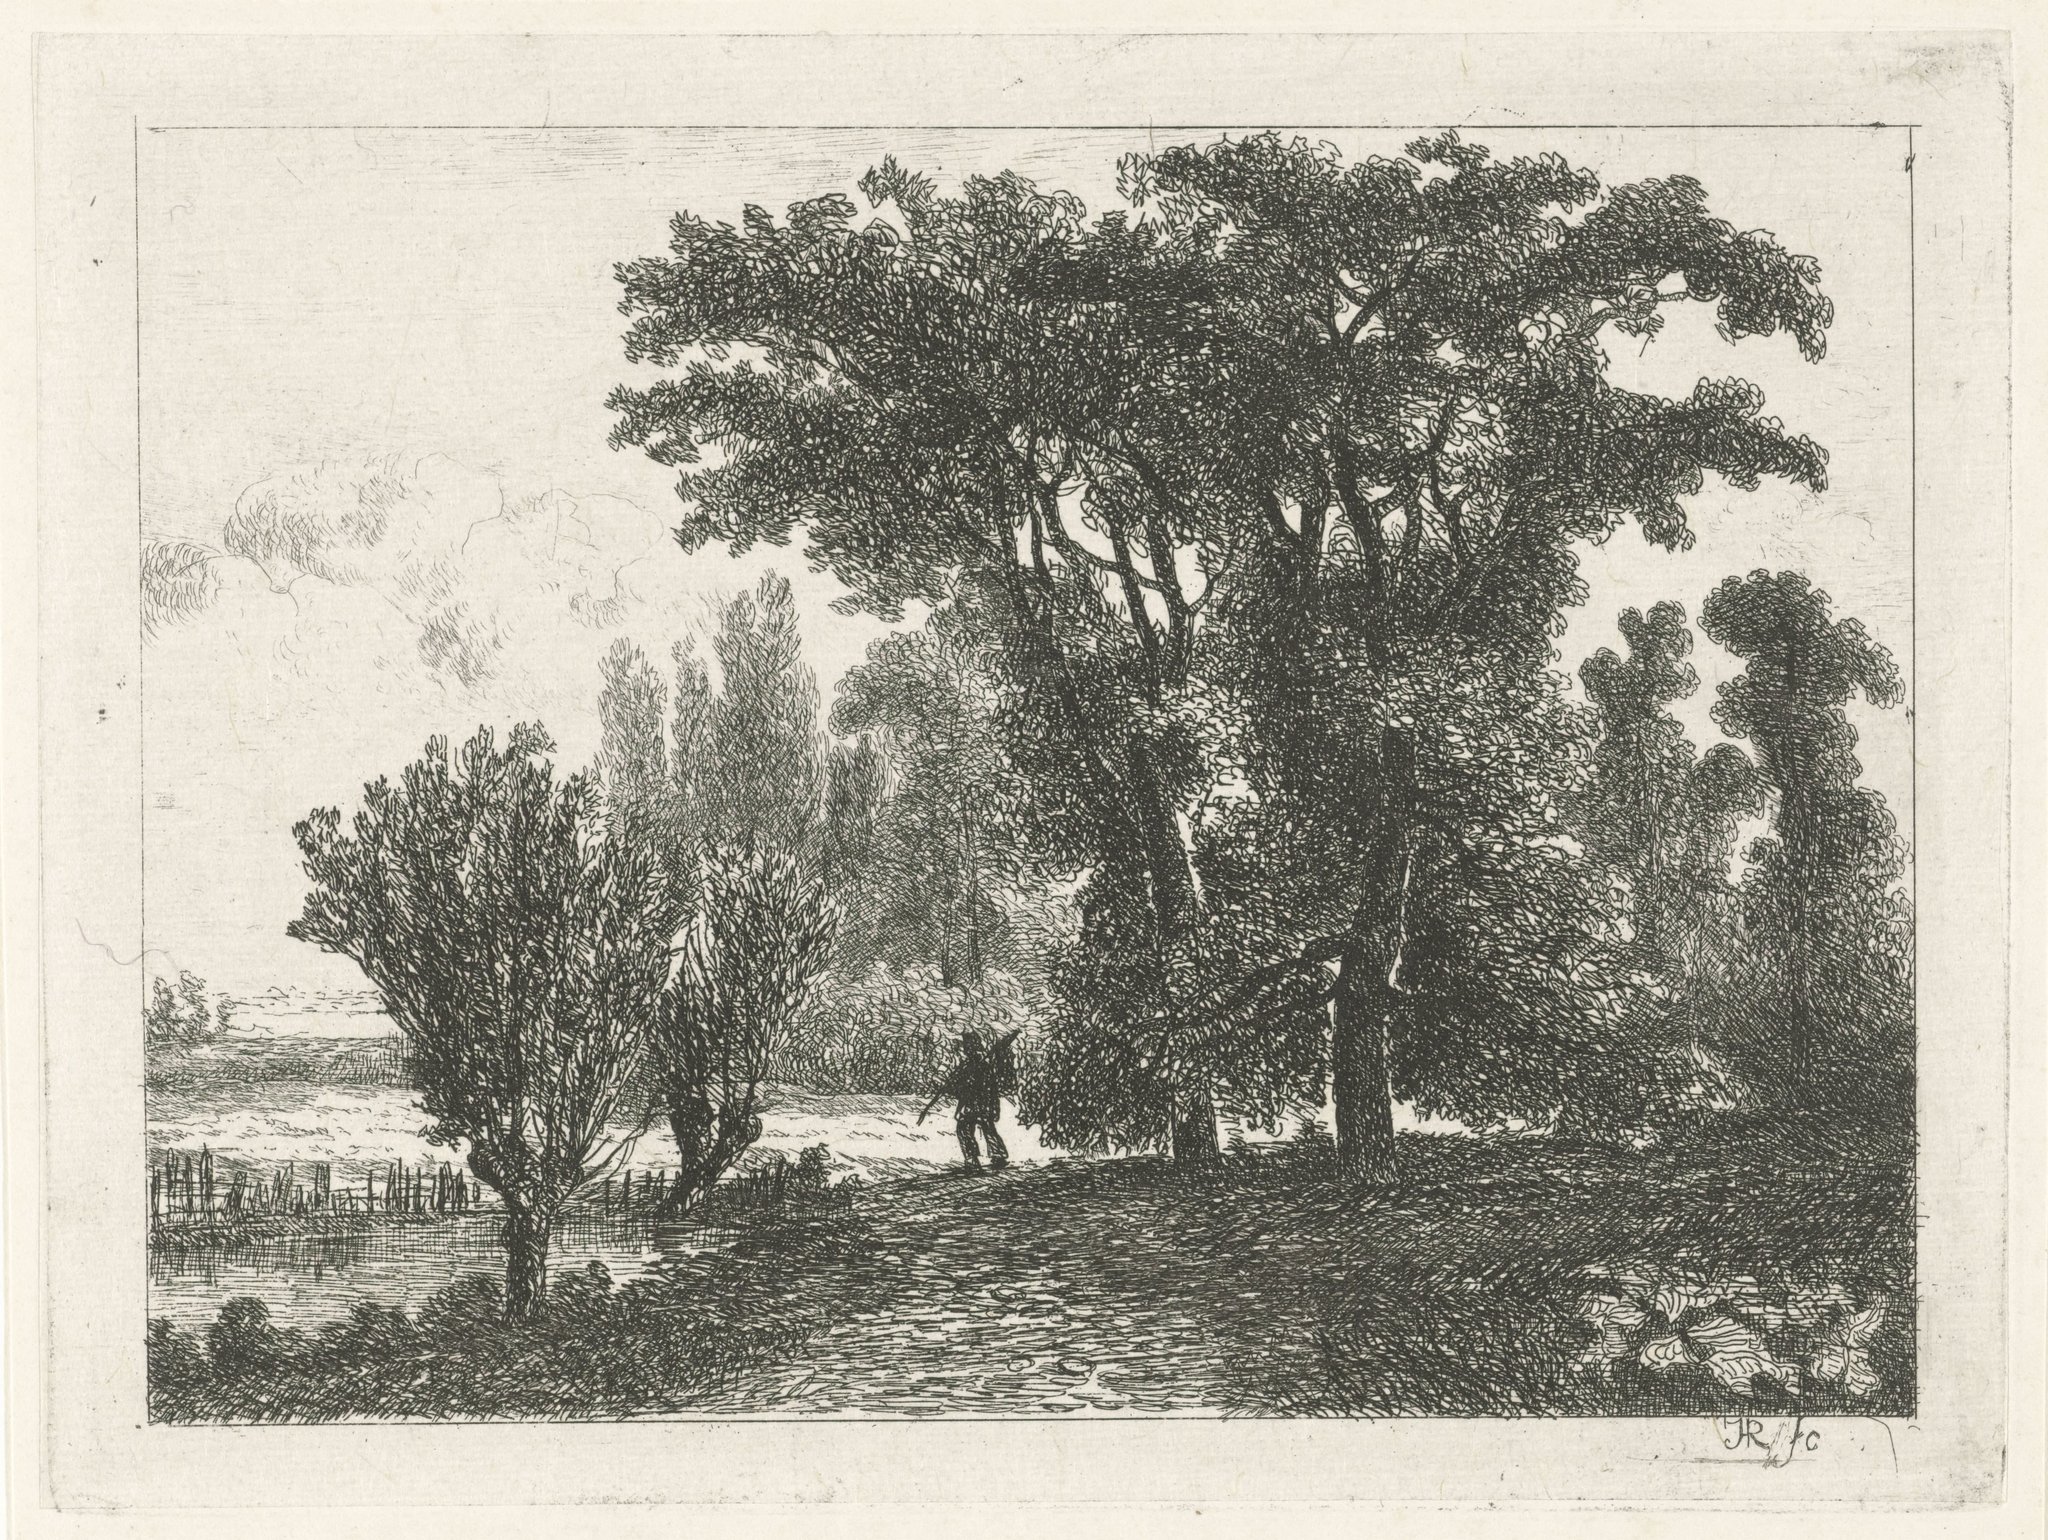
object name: print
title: Jager bij een bosrand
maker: hermanus jan hendrik van rijkelijkhuysen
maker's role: painter, print maker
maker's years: 1813-1883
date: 1864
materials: paper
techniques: drypoint, etching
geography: utrecht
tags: hunter, forest, wood, pond, pool, trees: willow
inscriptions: collector's mark: Lugt 2228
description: Gezicht op de rand van een bos en een meertje, waar twee knotwilgen naast staan. Over een bospad loopt een jager.